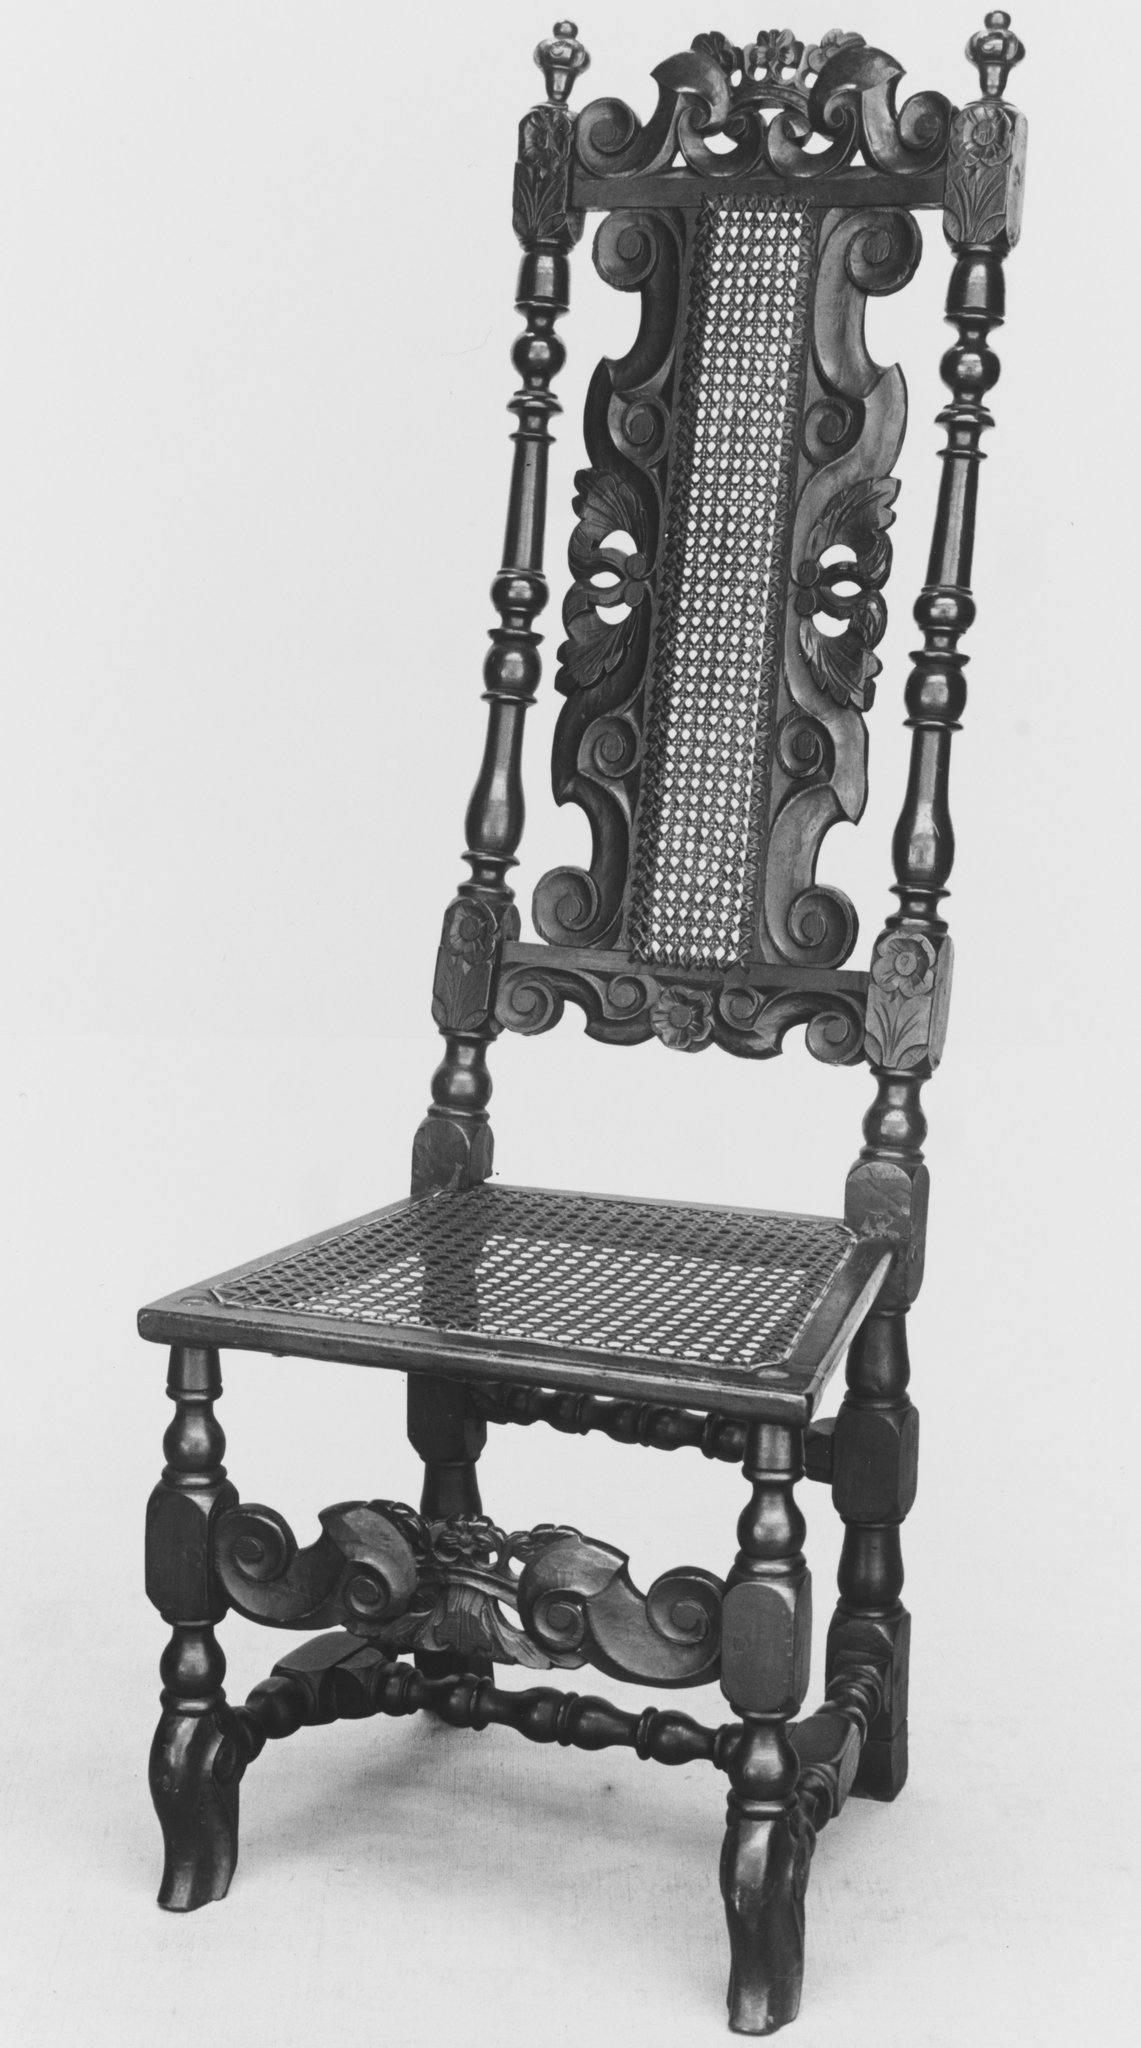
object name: side chair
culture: british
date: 1690-1710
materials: wood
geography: england